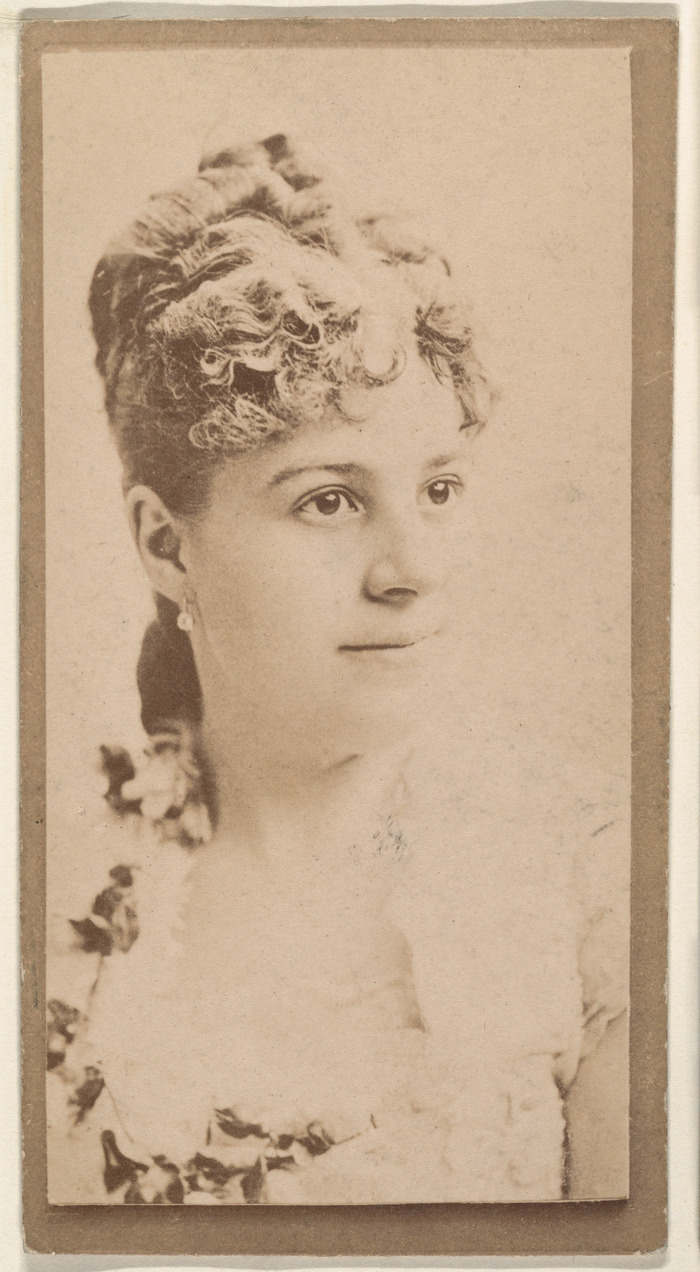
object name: photograph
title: Actress wearing dress with floral neckline, from the Actresses series (N668)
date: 1888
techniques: albumen silver print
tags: portraits,women,actresses